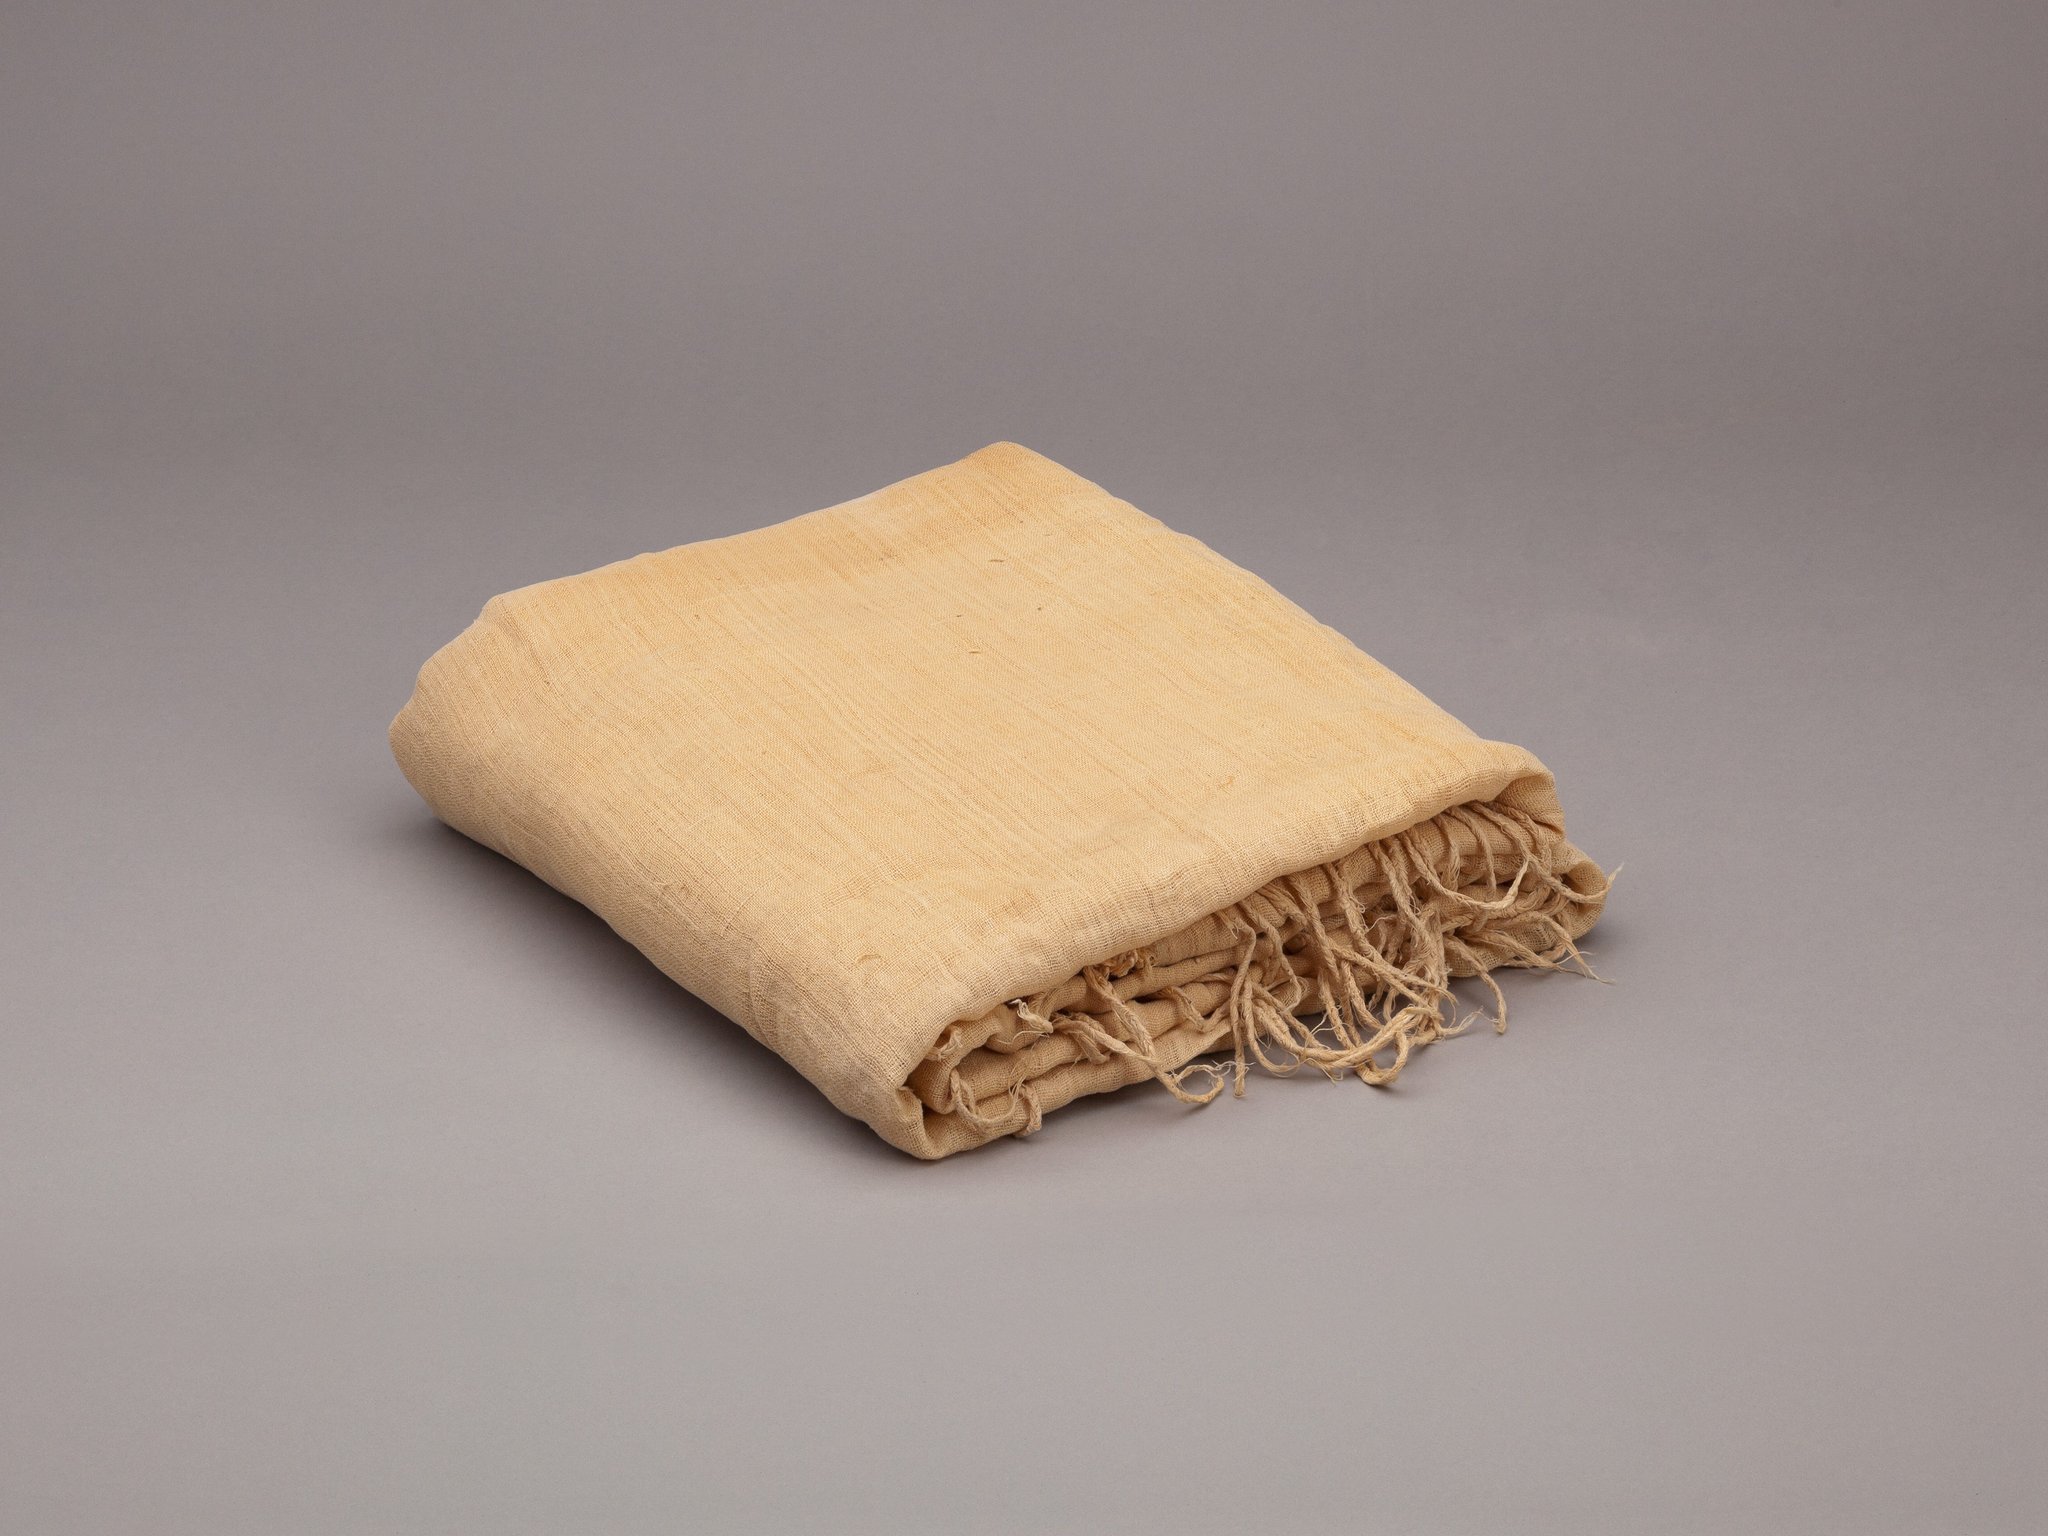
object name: linen mark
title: Sheet, linen mark, coarse spin, medium weave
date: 1492-1473 BCE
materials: linen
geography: egypt